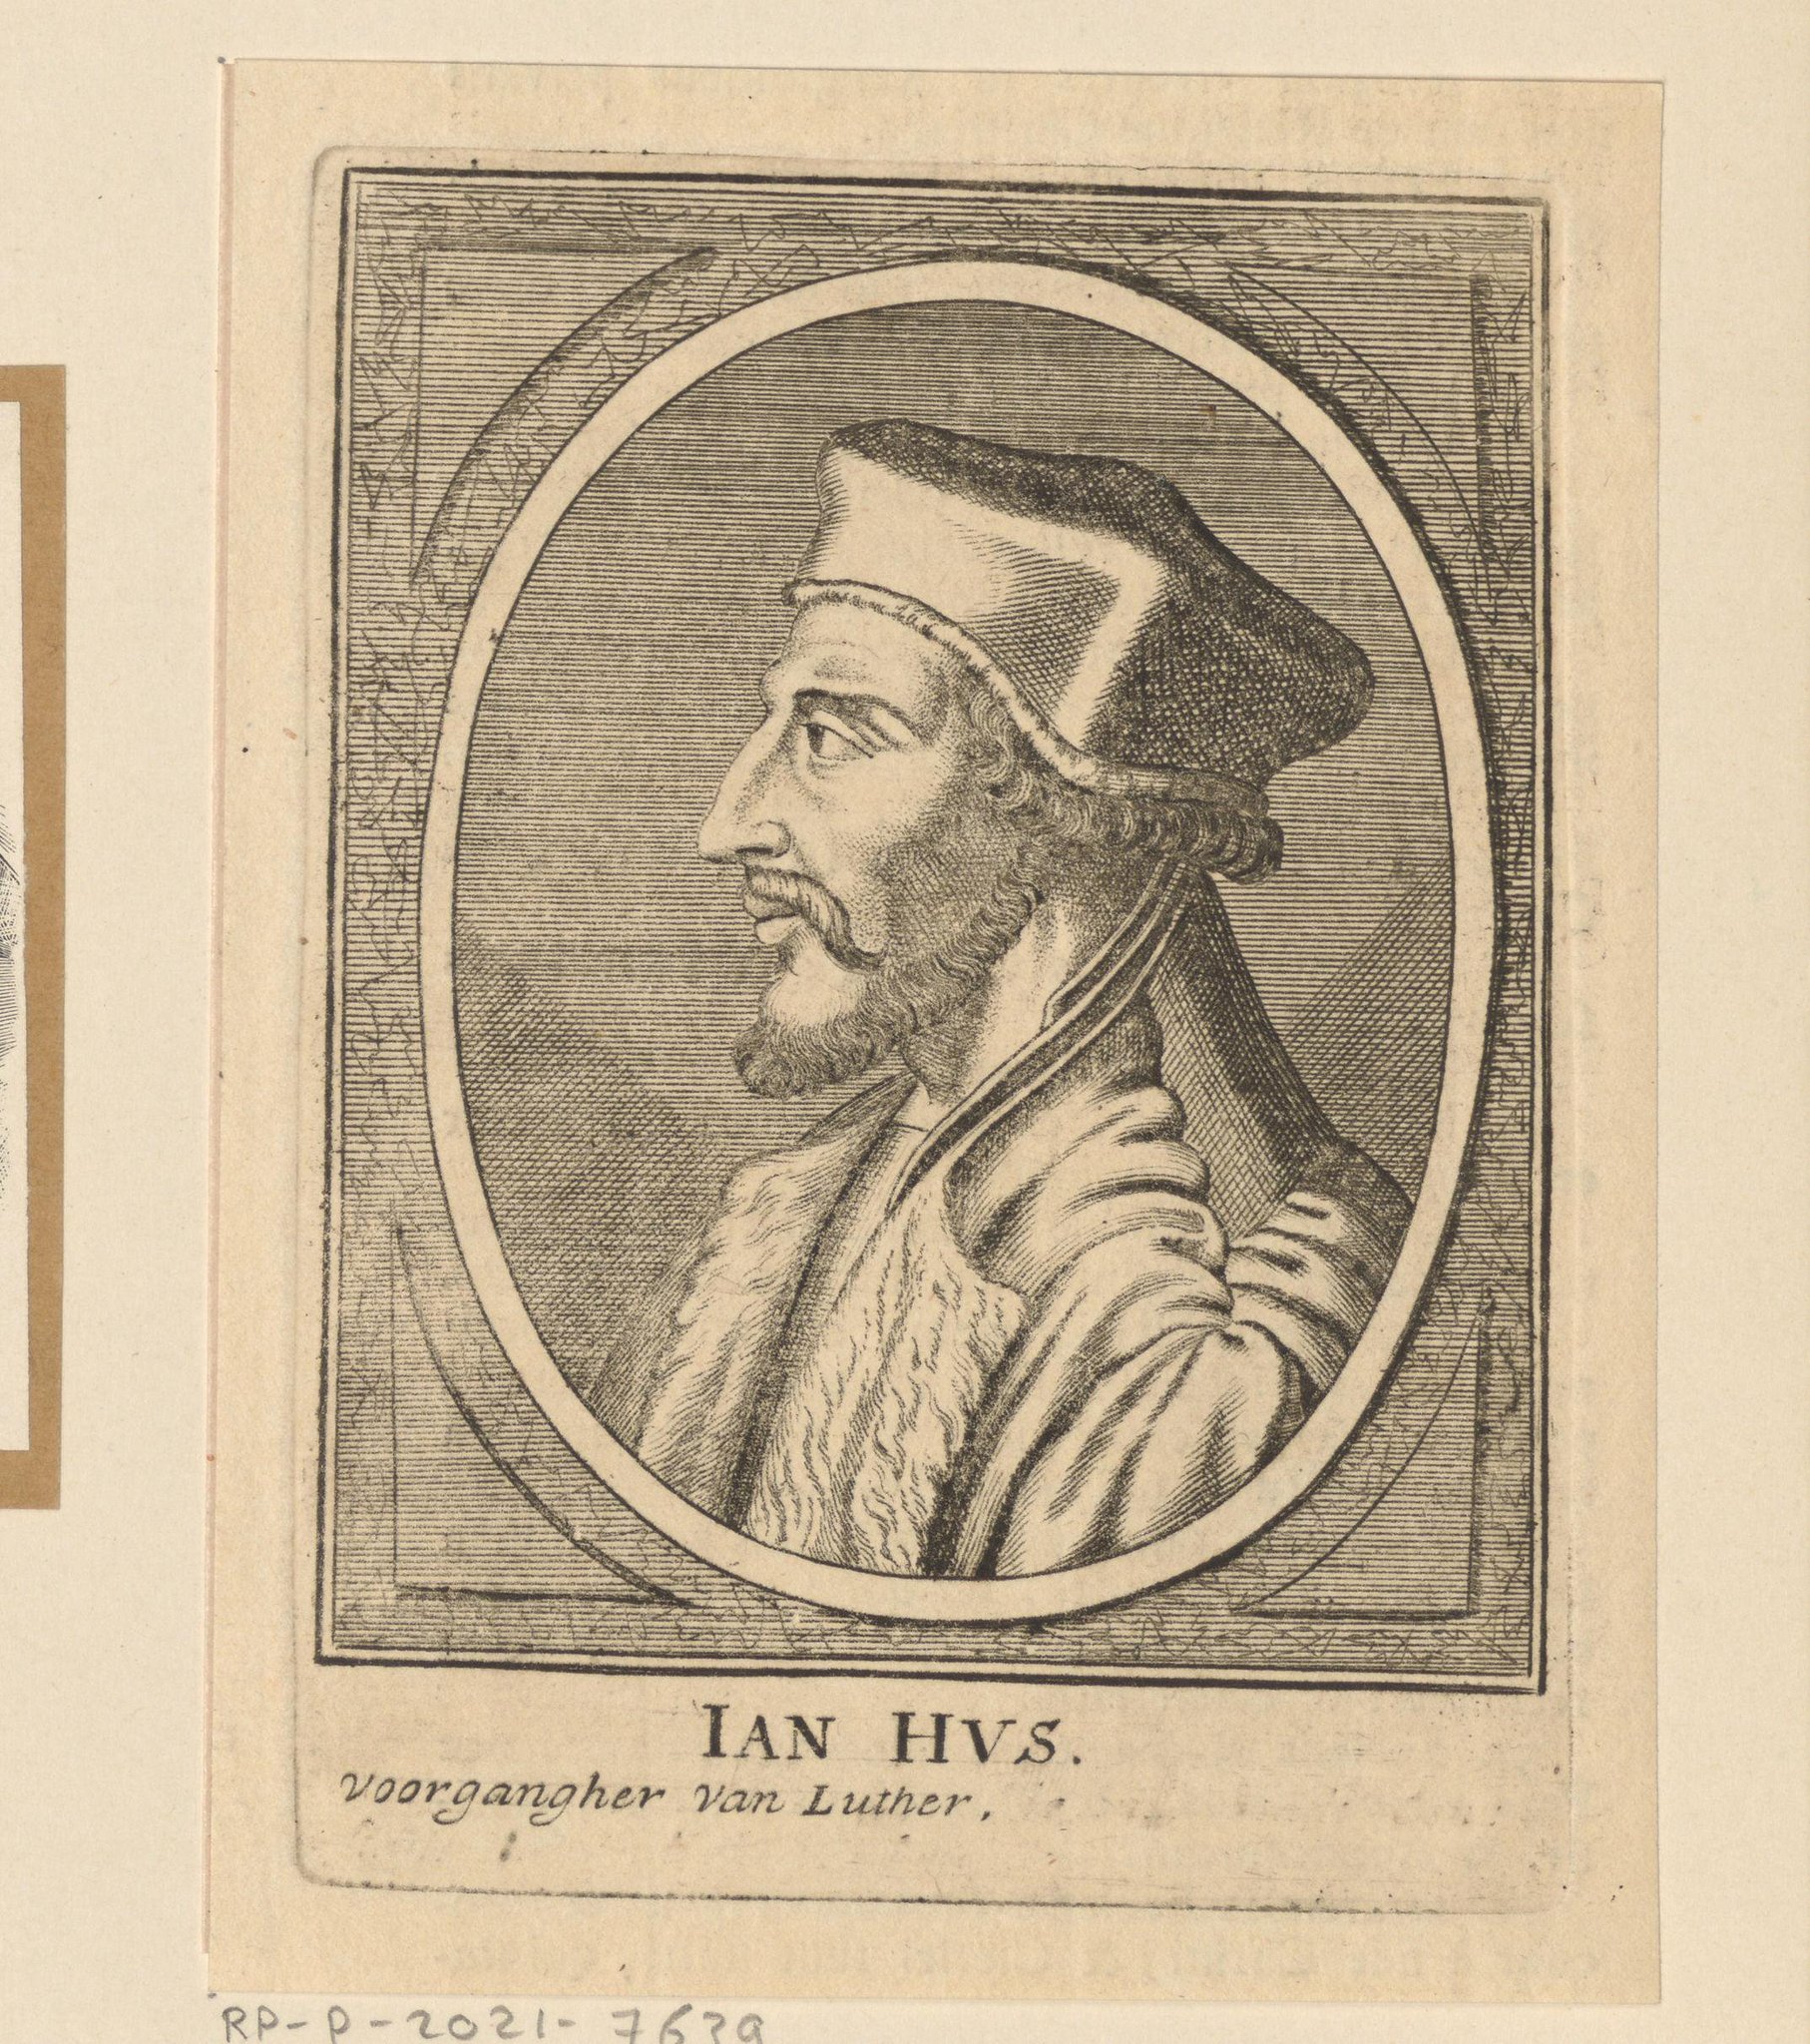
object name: print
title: Portret van Johannes Hus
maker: Anonymous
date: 1675-1724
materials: paper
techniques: engraving, etching, letterpress printing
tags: theologian, historical persons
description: Eerdere staat van de prent met omlijsting gebruikt in: Raemond, Florimond de. Opgang, voortgang, en nedergang, der ketteryen deser eeuwe (...). Antwerpen: Hieronymus Verdussen, 1690.